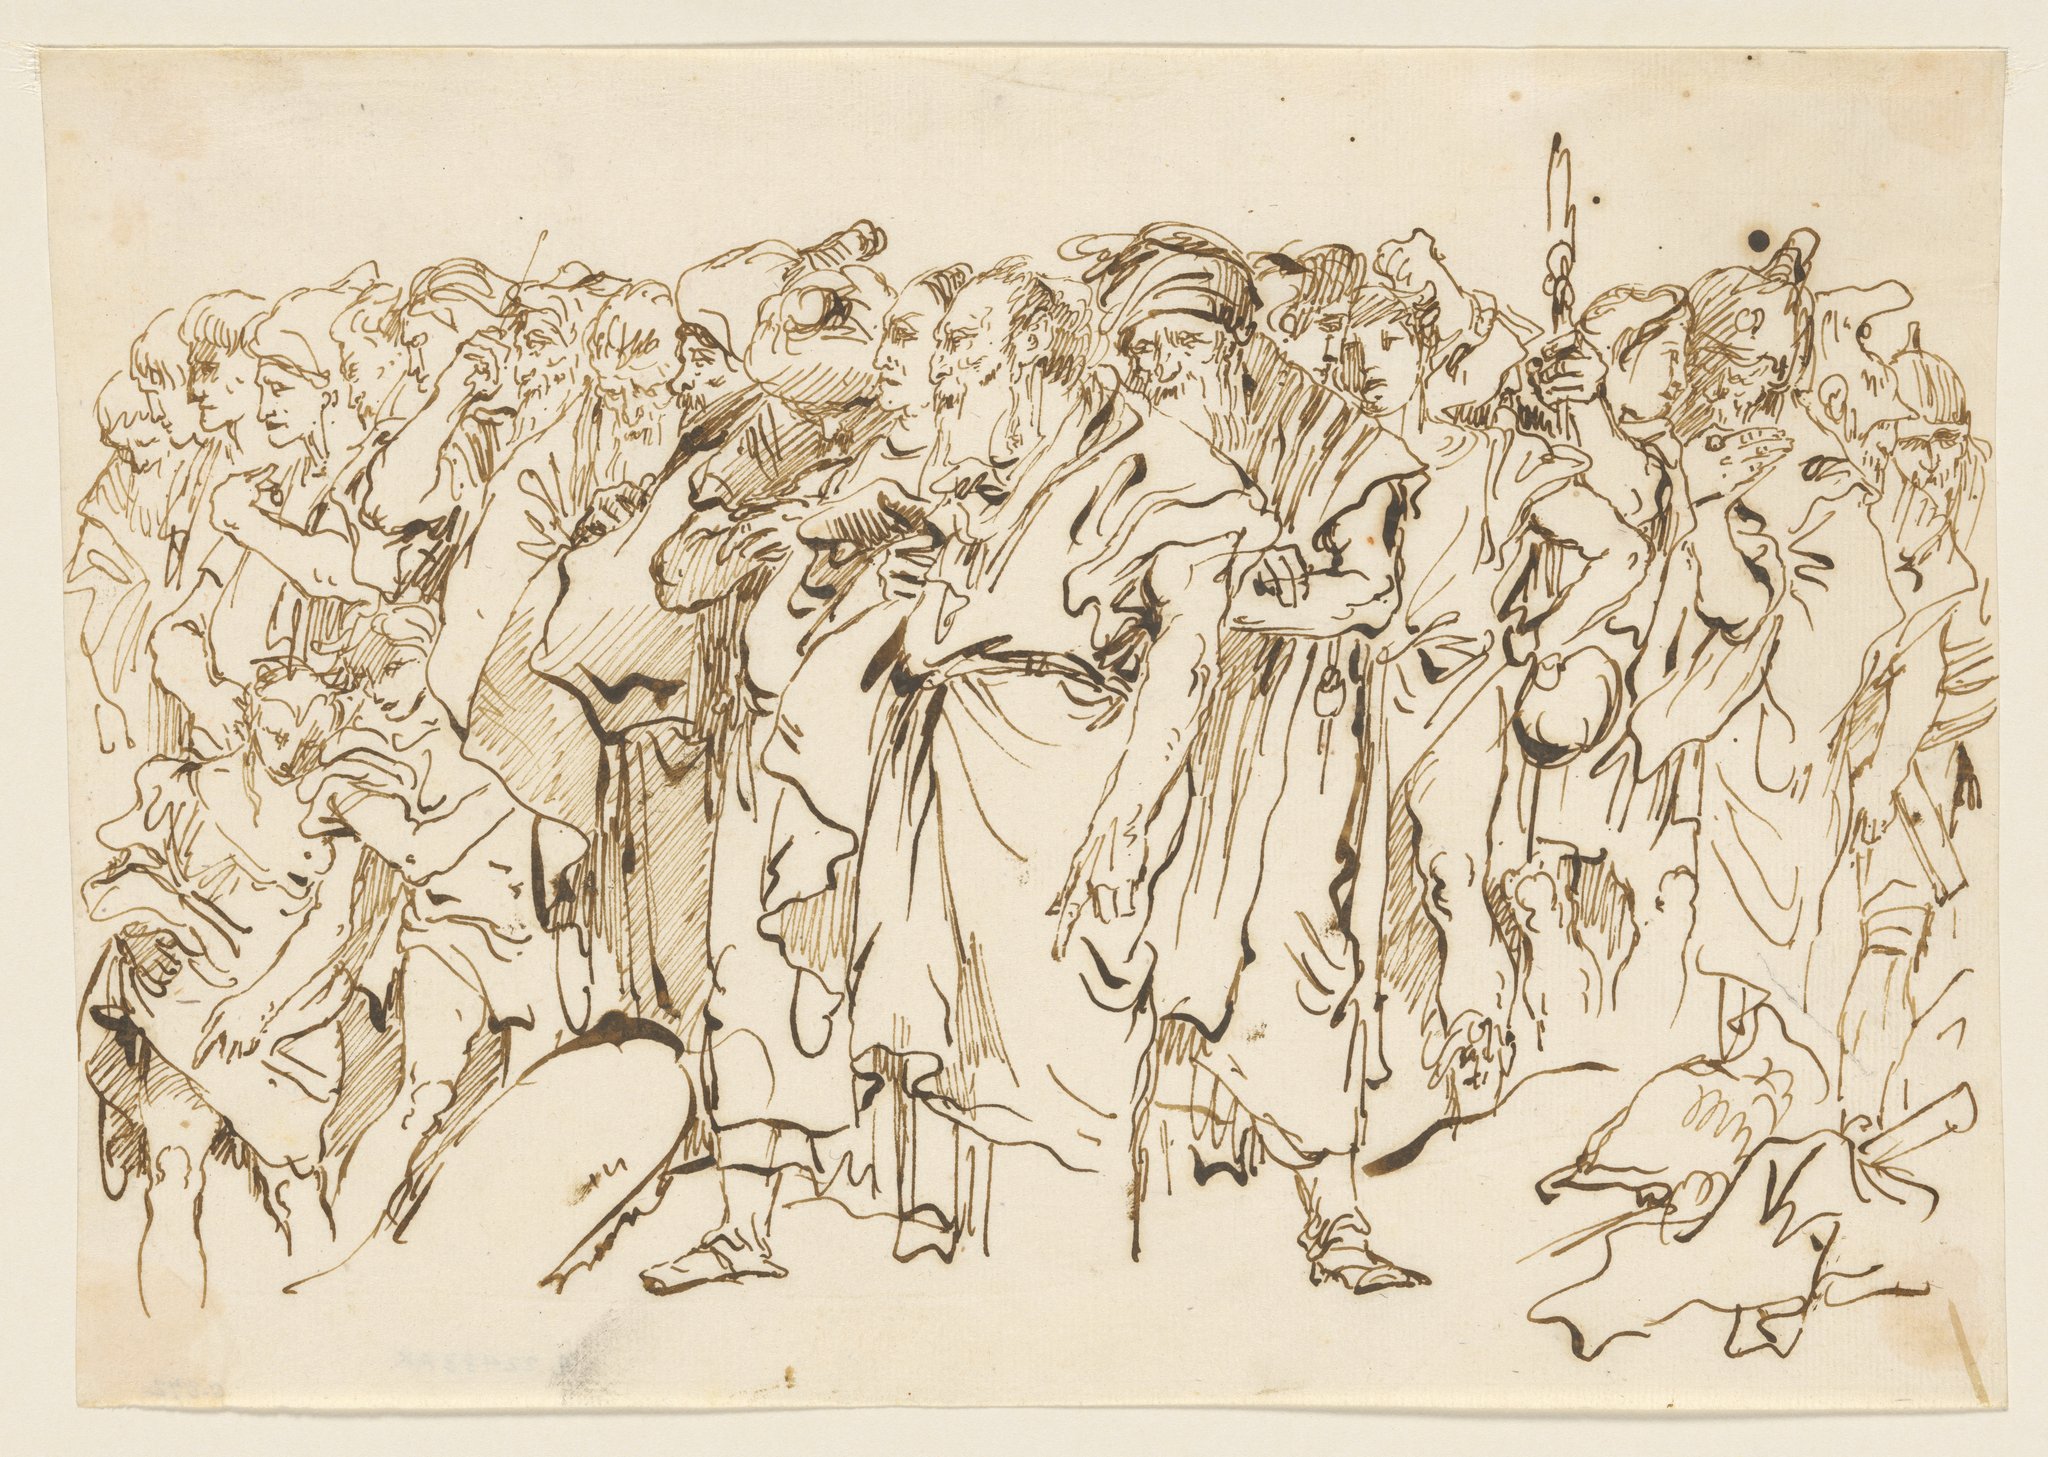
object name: drawing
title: A Crowd of Ancient Warriors, Orientals, and Two Boys, Gathering for a Sacrifice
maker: giovanni domenico tiepolo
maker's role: artist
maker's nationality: italian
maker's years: 1727-1804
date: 1743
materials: ink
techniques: pen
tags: boys,crowd